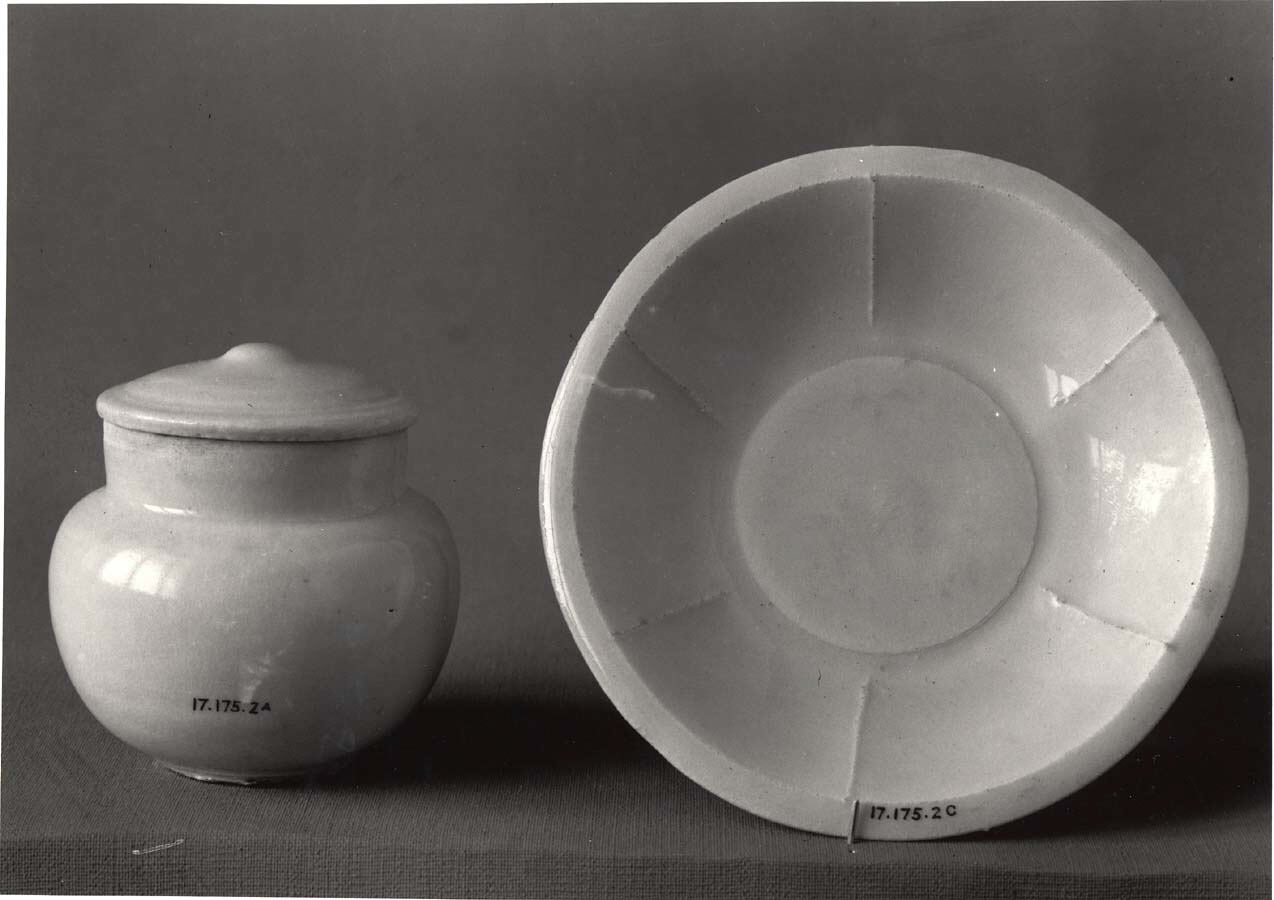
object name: jar with cover and saucer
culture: chinese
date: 801-1000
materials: porcelain